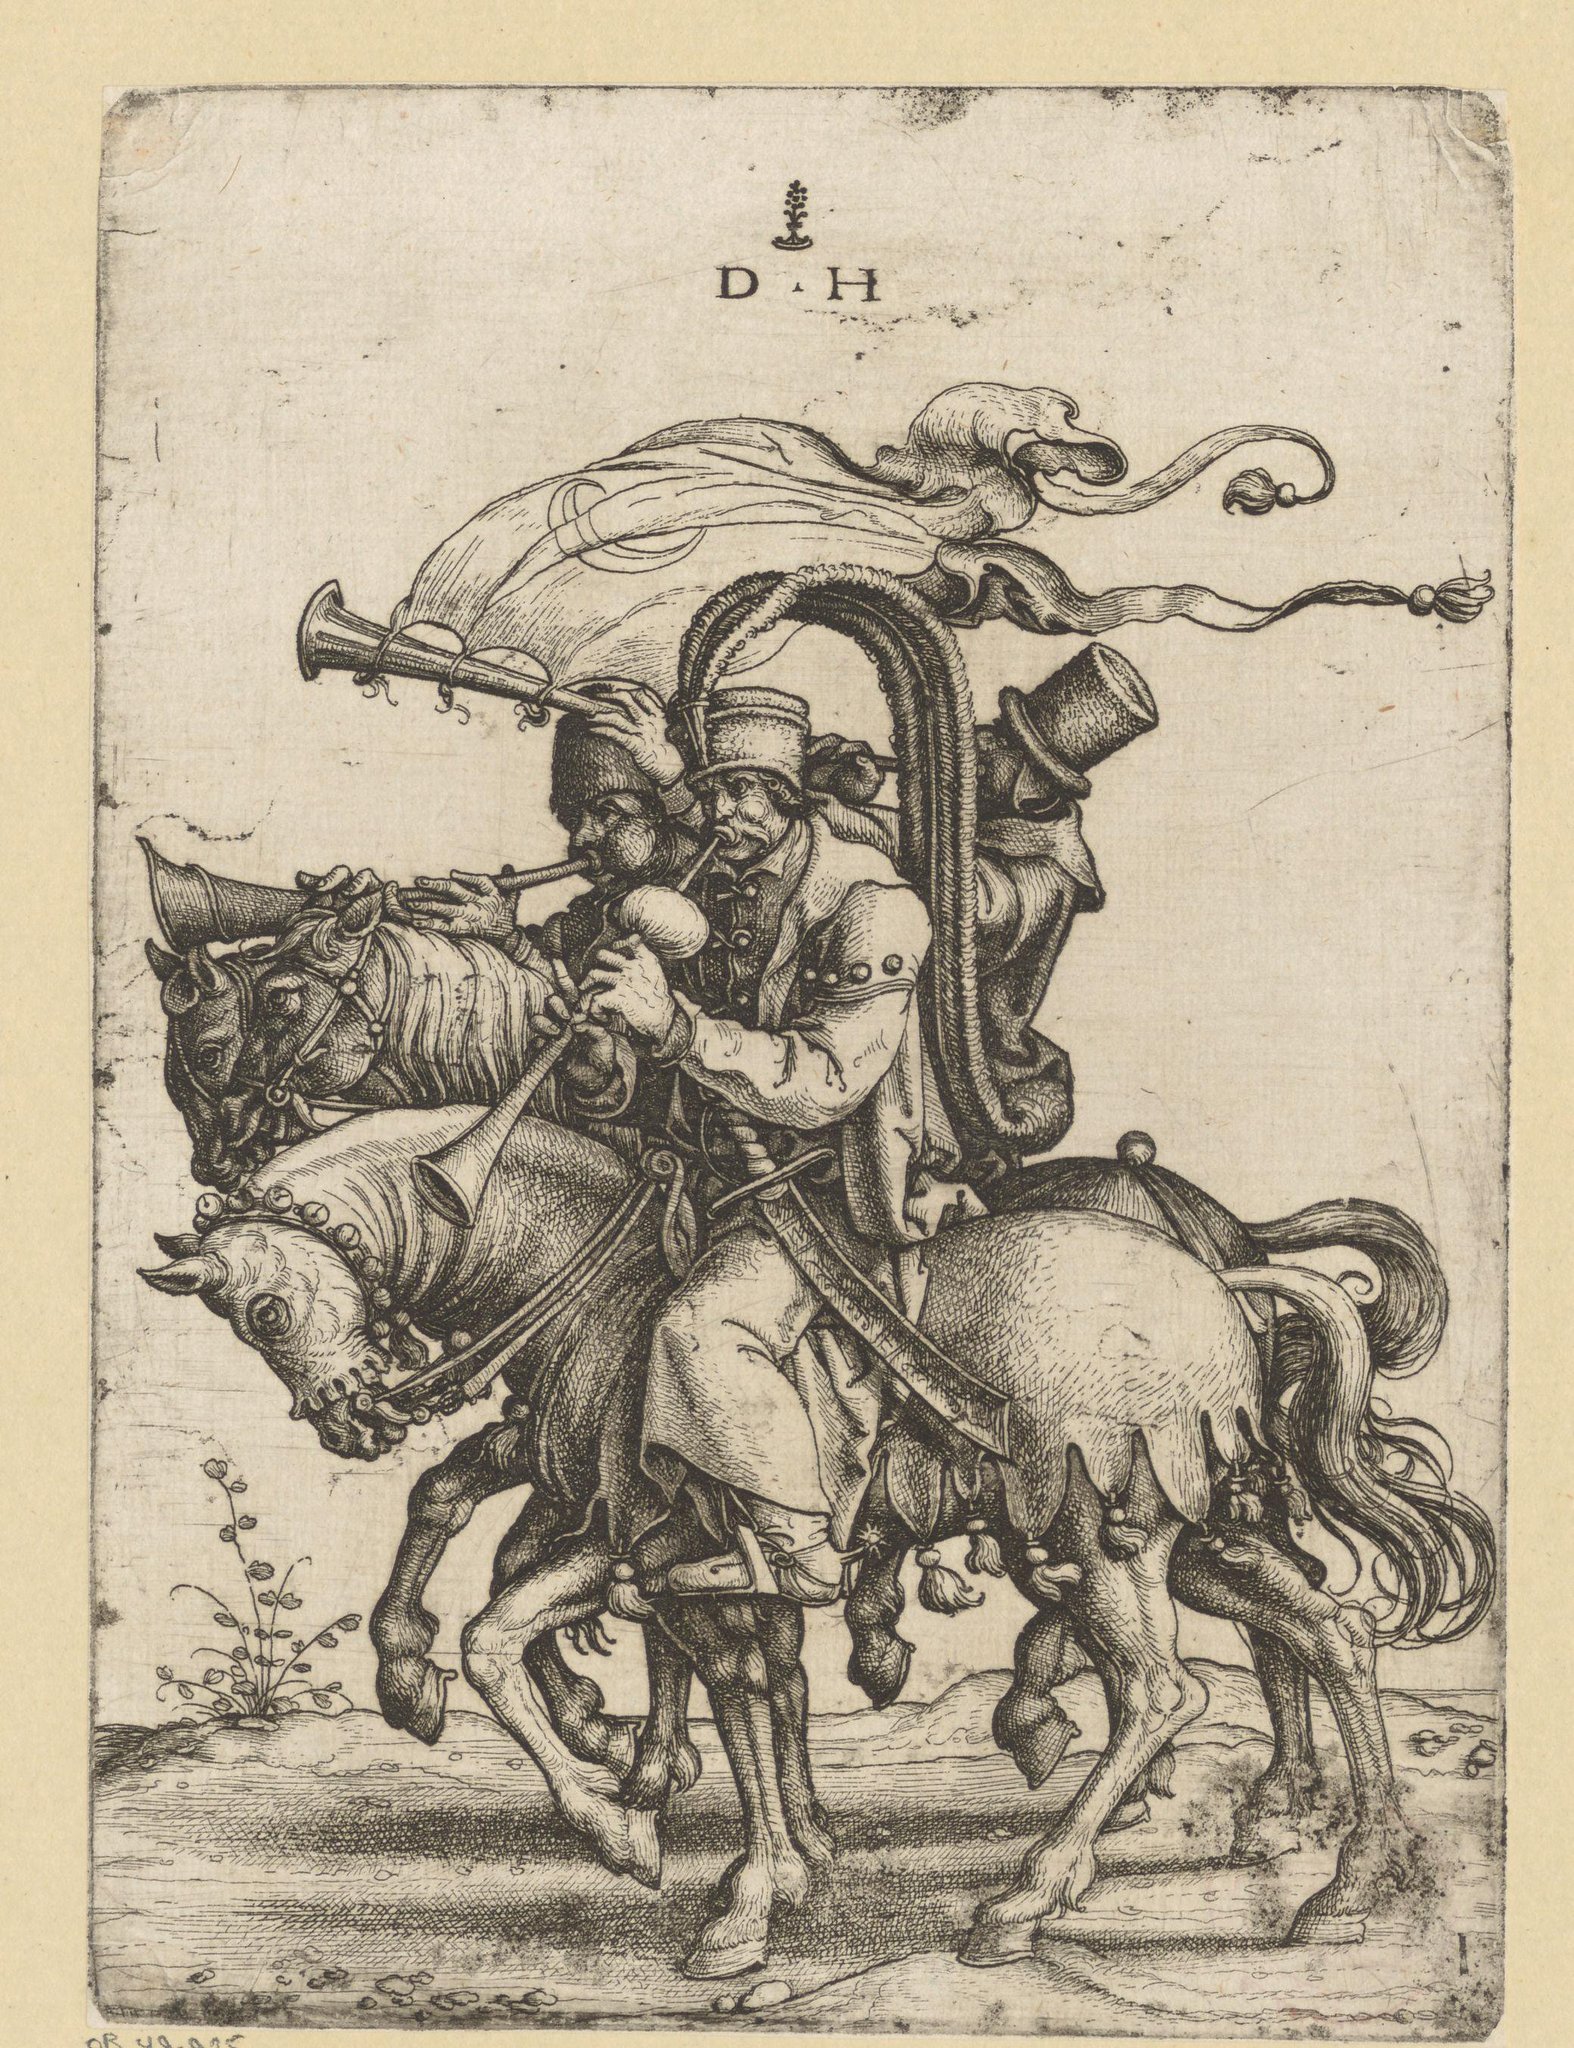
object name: print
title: Trompettist en twee hoboïsten te paard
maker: daniel hopfer (i)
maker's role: print maker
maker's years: 1470-1536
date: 1530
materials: paper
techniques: etching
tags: making music; musician with instrument, triumphal entry and public reception, pageant, 'entrée solennelle', 'joyeuse entrée', military parade, pageant, (military) uniforms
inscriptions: collector's mark: Lugt 240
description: Deze prent is onderdeel van een serie naar Jan Swart's ontwerp uit 1526 met vijf prenten van Kanu Sultan Süleyman en zijn cortège, getiteld 'Soleiman de Grote en Turkse ruiters'.